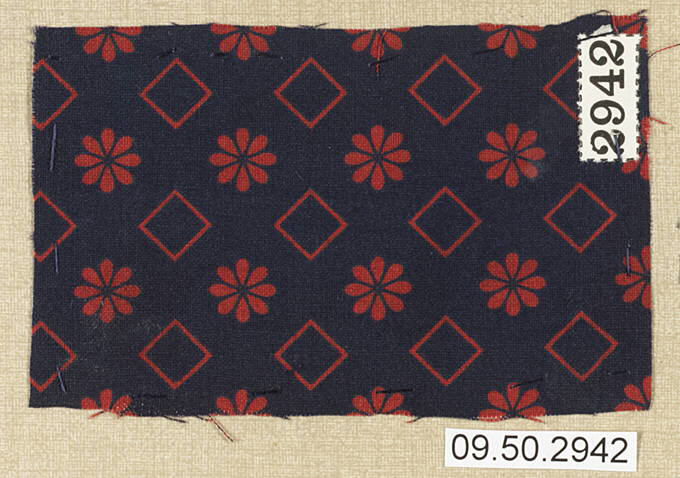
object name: piece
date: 1801-1900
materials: cotton